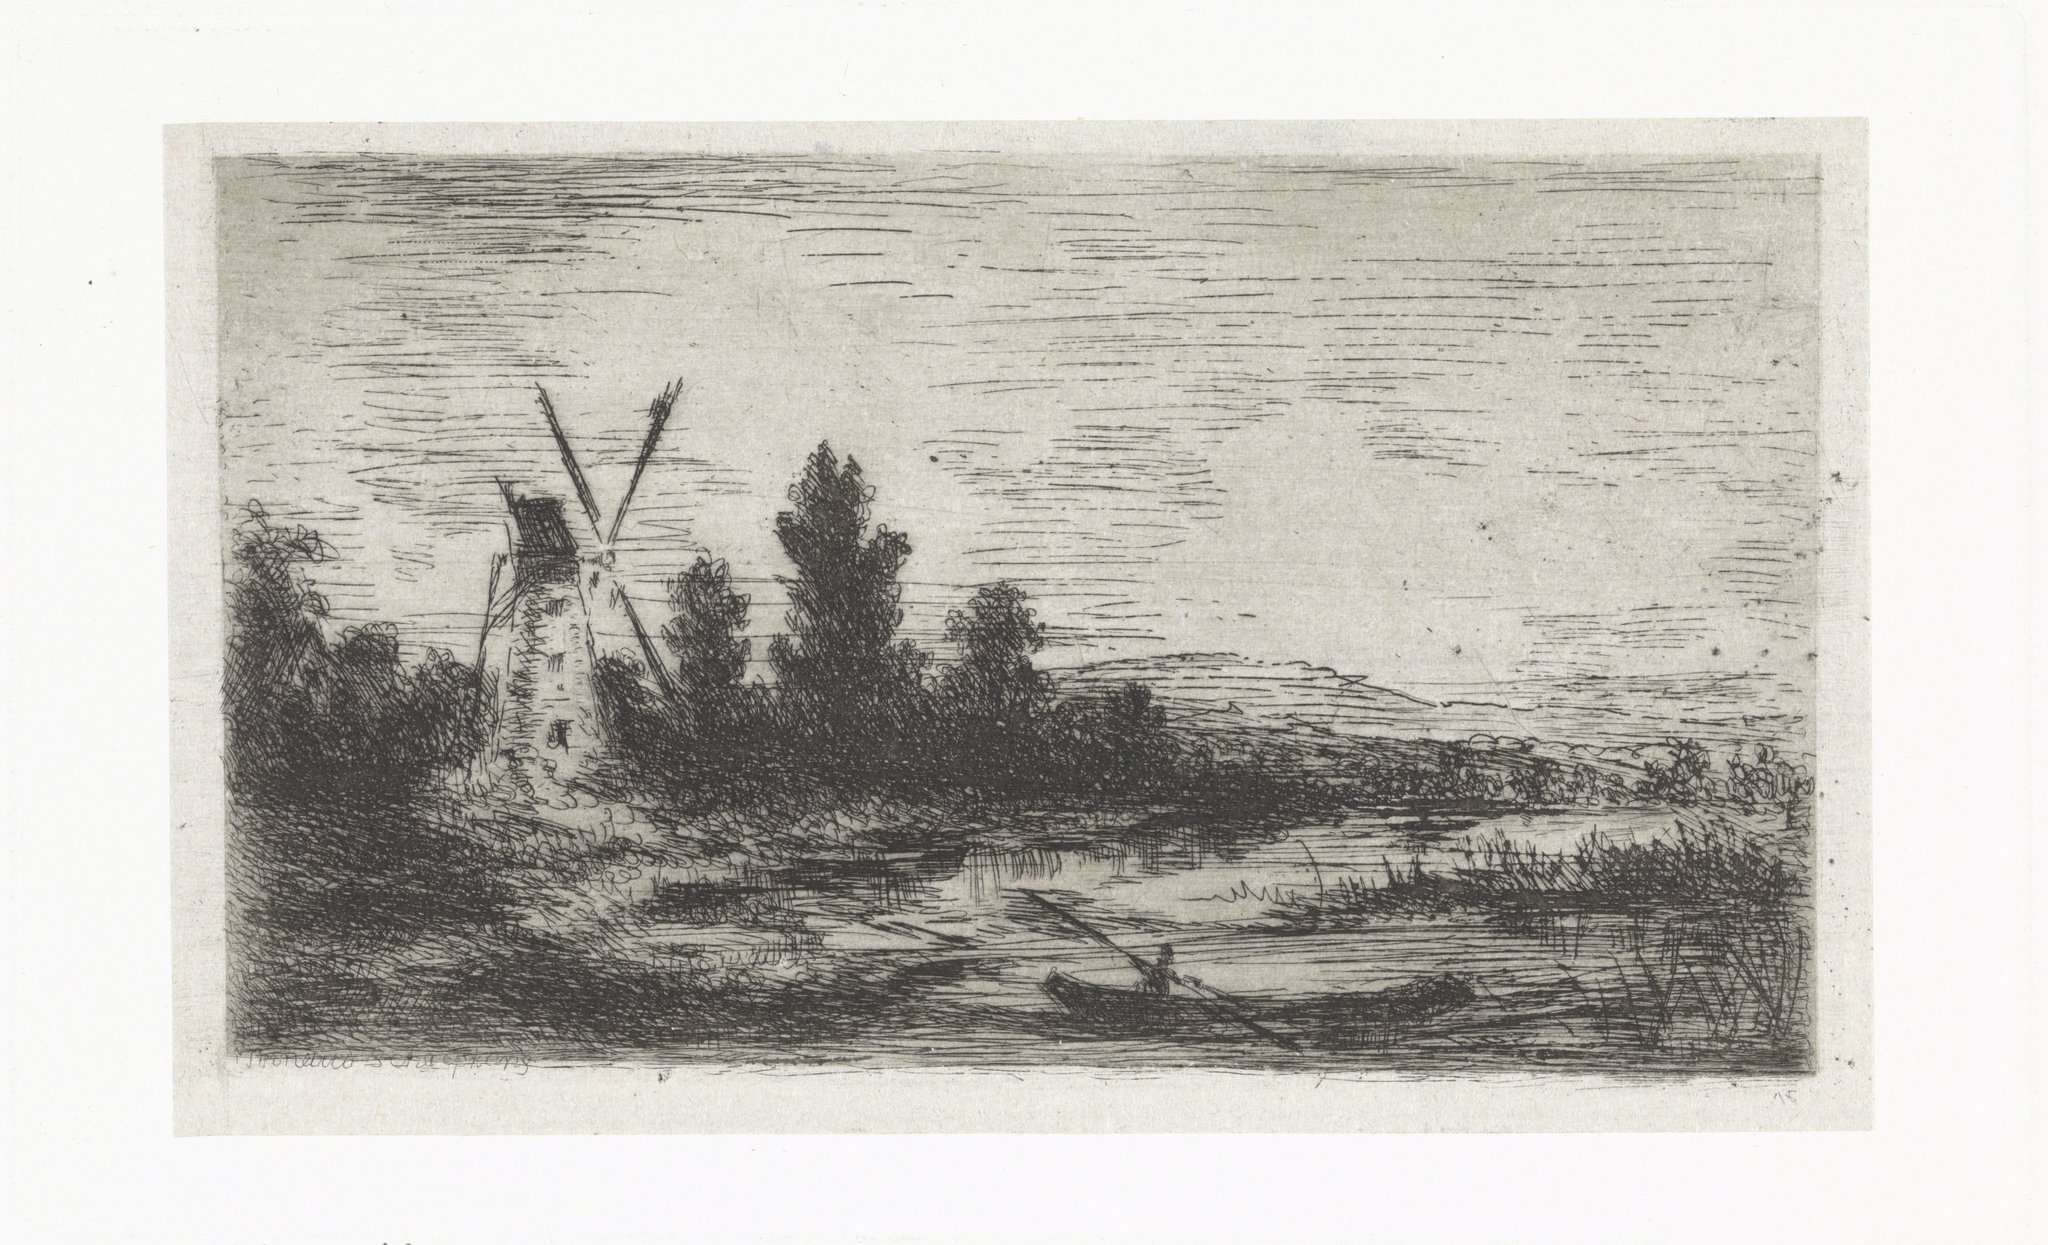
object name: print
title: Waterrijk landschap met molen en roeiboot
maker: arnoud schaepkens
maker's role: print maker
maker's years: 1816-1904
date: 1831-1888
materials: paper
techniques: drypoint, etching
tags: landscapes with waters, waterscapes, seascapes (in the temperate zone), windmill in landscape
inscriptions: collector's mark: Lugt 2228